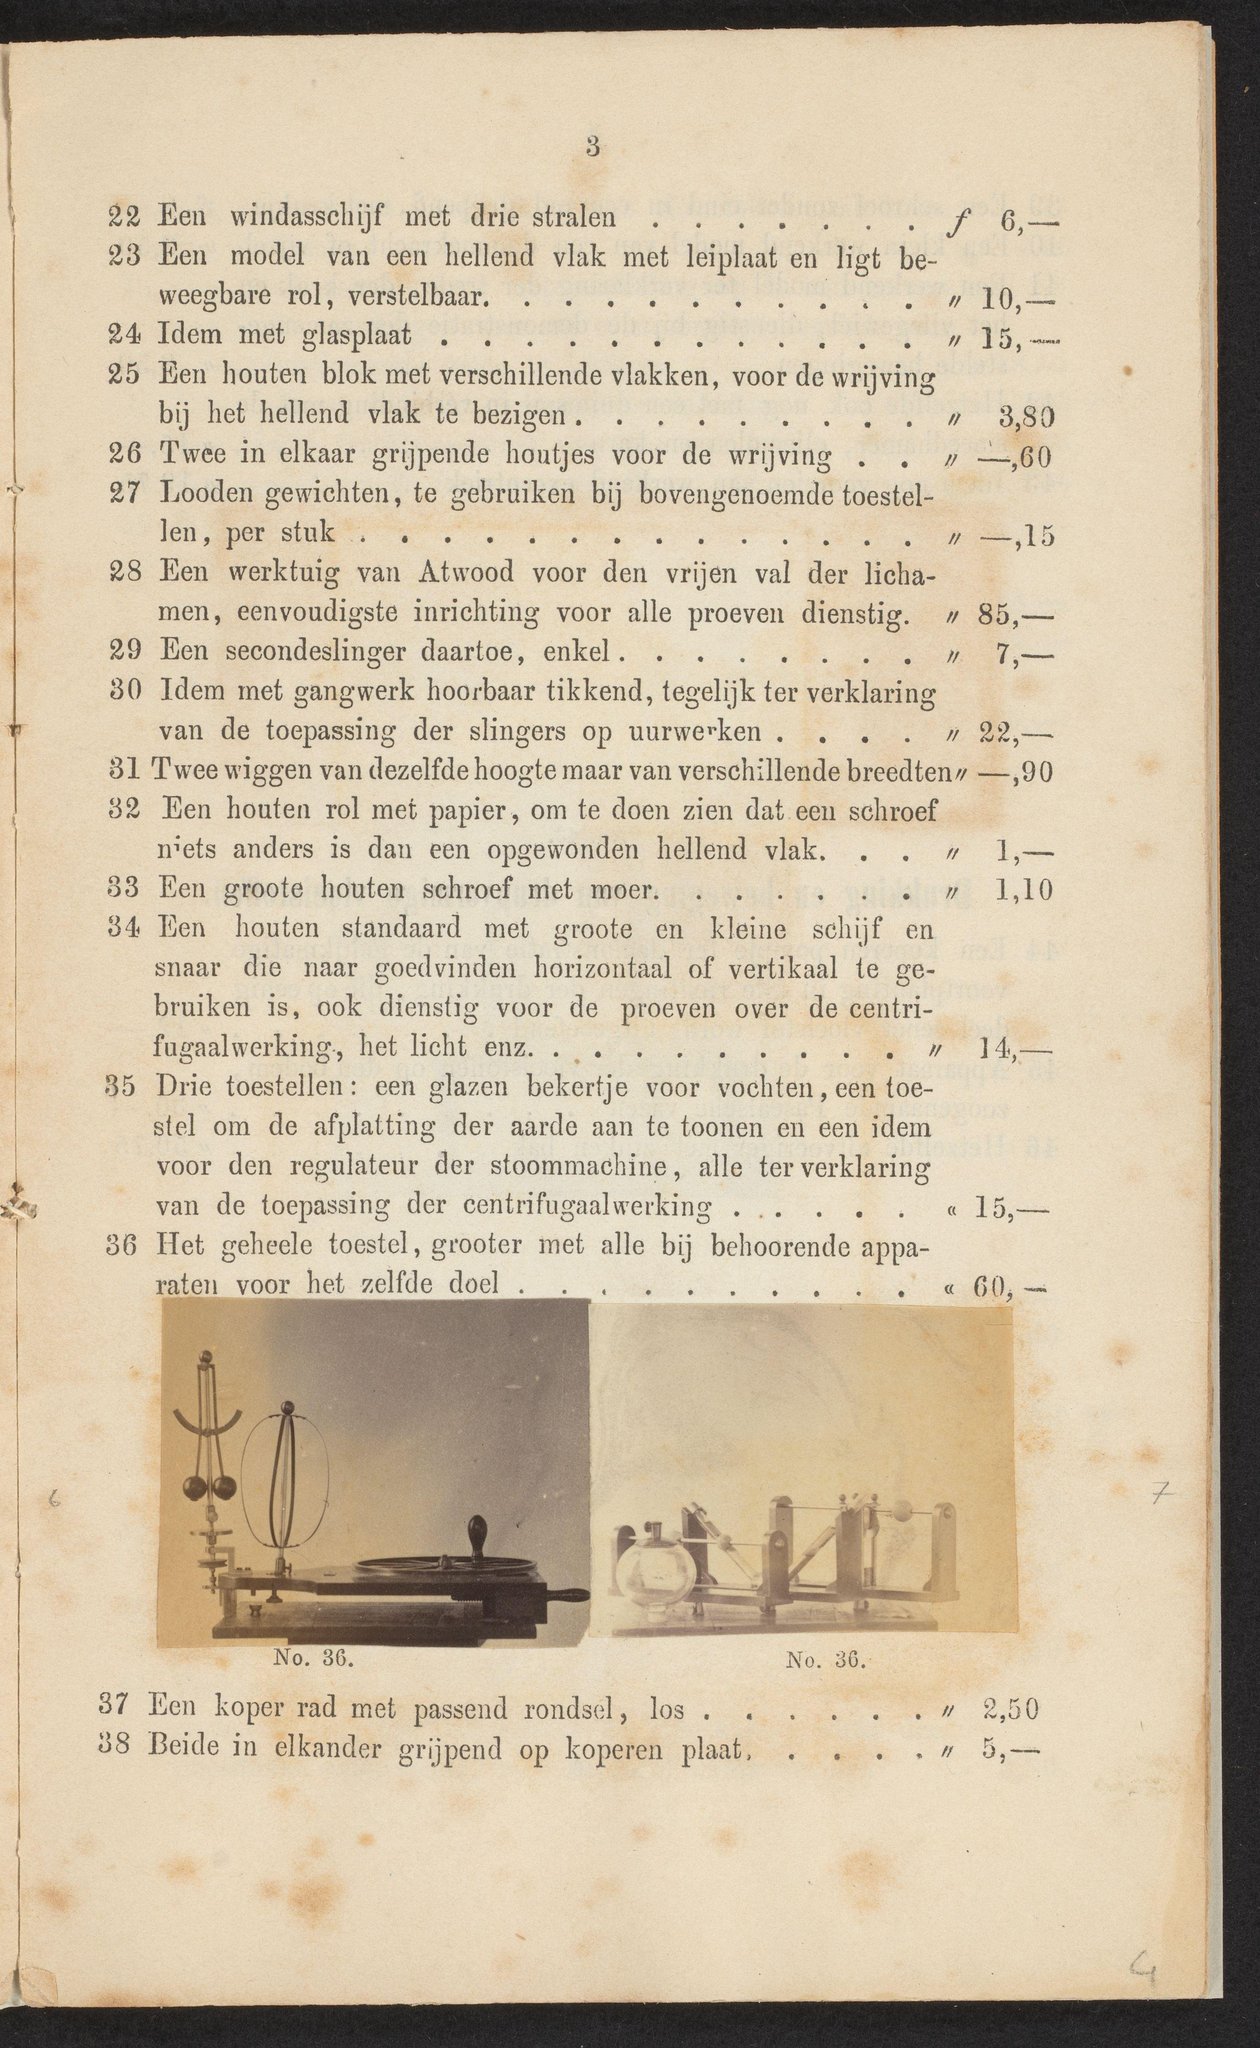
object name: photograph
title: Natuurkundig instrument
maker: fredrich wilhelm funckler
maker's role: instrument maker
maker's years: 1836-1886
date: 1857-1867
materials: paper, photographic support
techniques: albumen print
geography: netherlands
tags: physics (+ tools, instruments; laboratory equipment ~ scientific research)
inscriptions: number: ‘No. 36.’